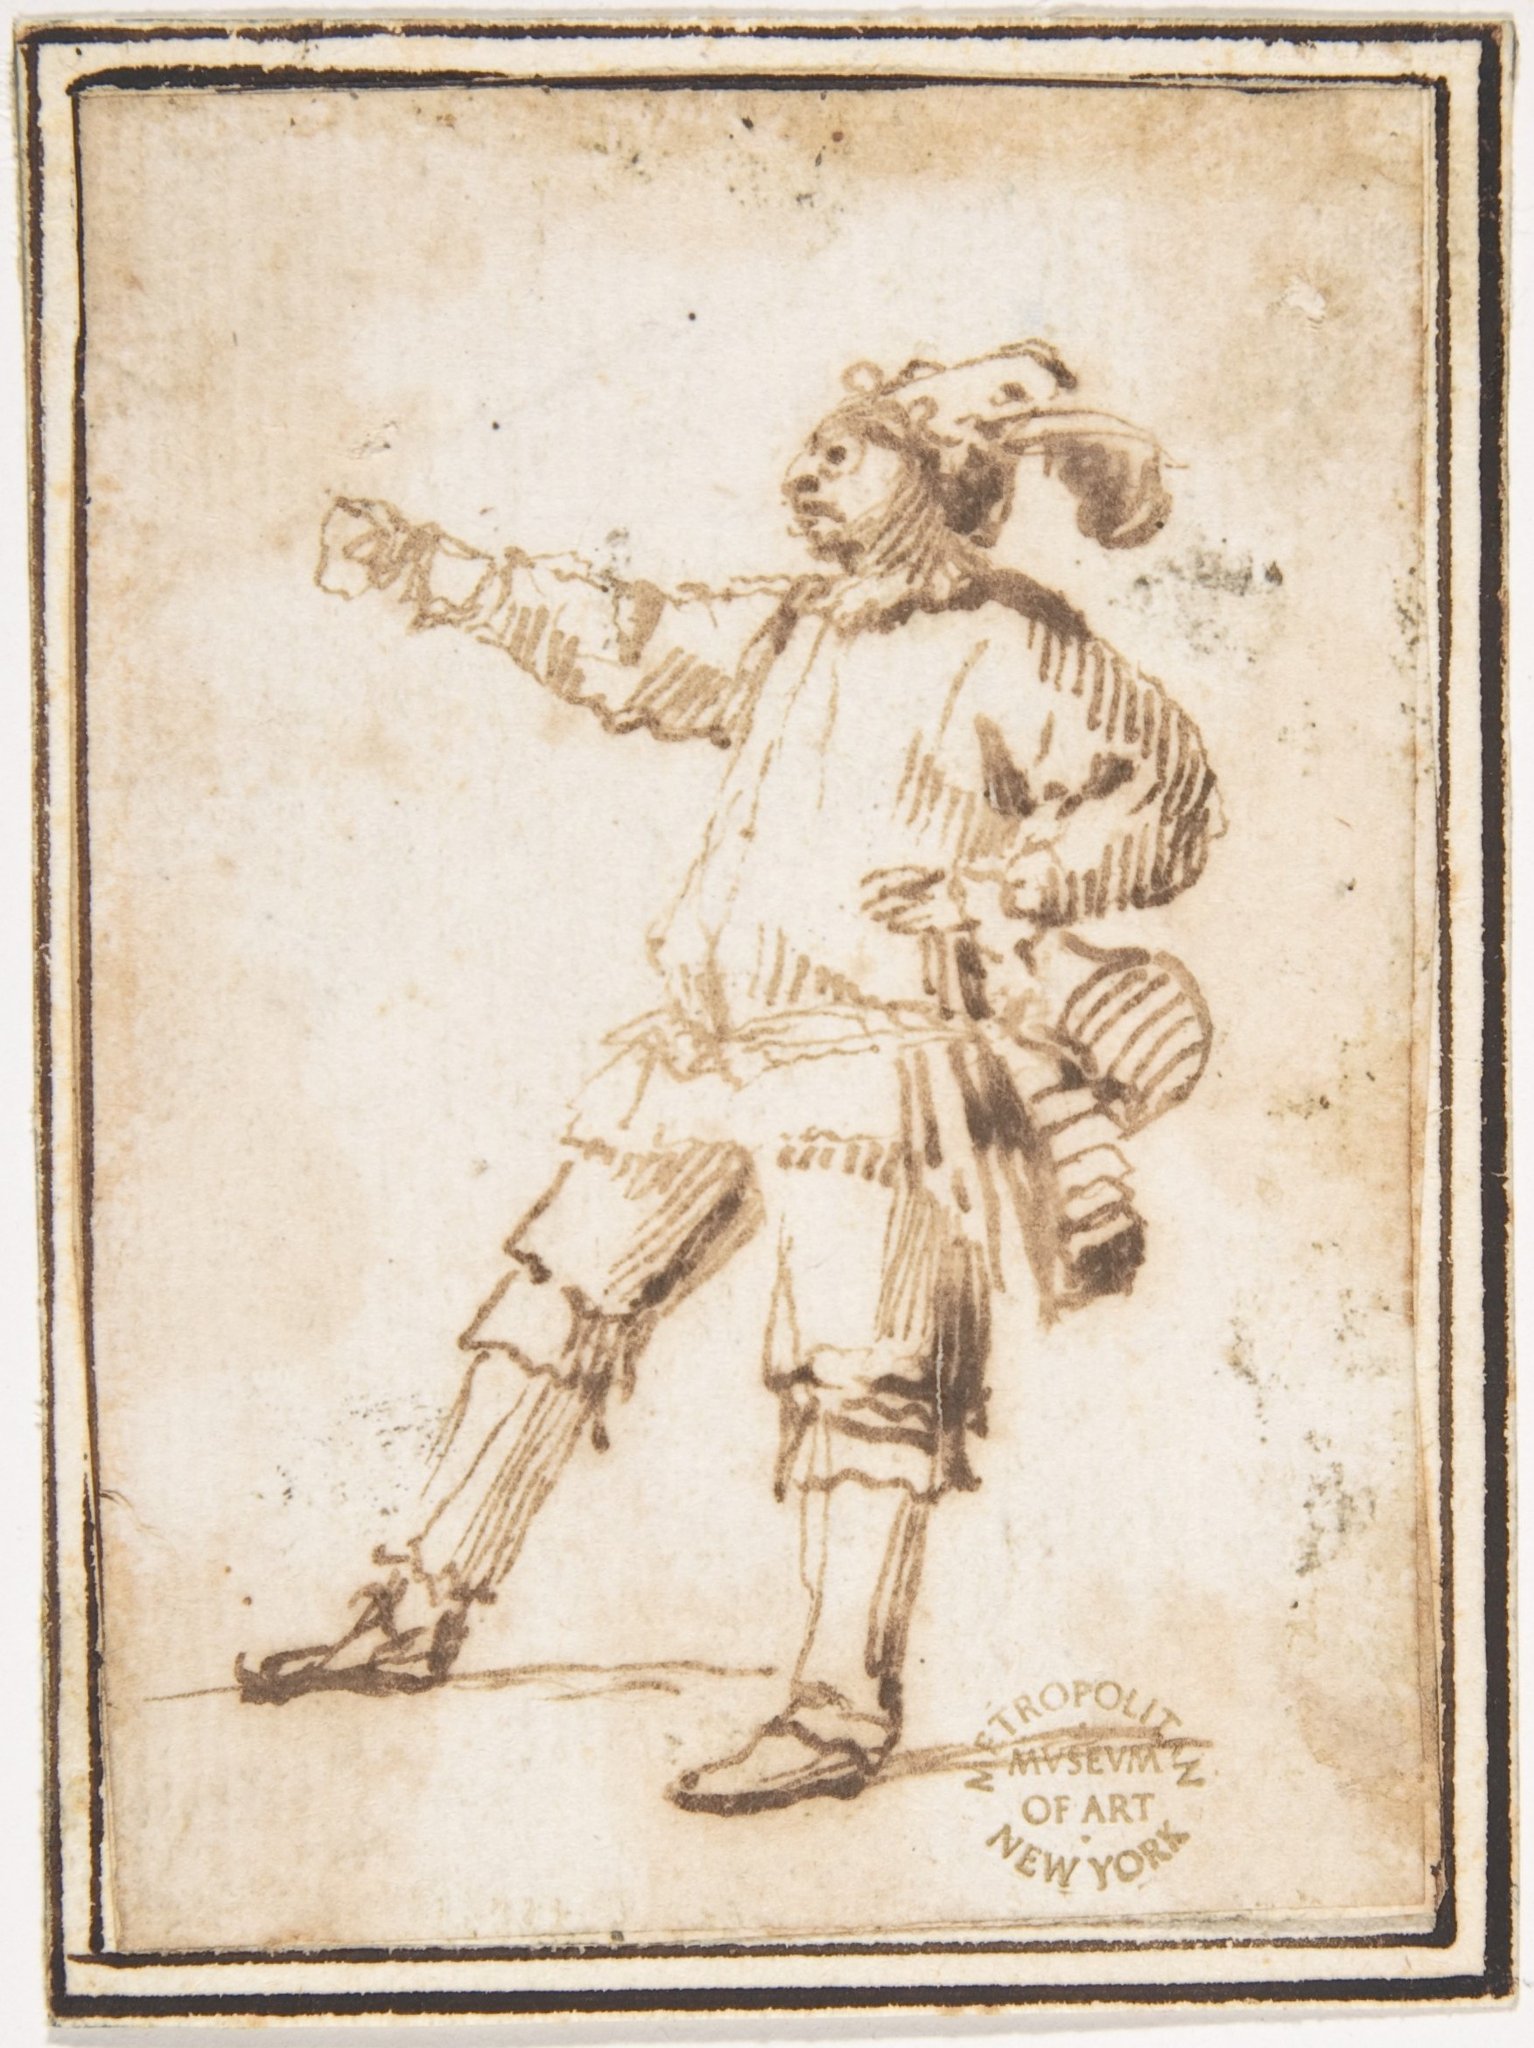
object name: drawing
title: Study of an Actor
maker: francesco allegrini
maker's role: artist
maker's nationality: italian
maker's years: 1615-1679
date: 1624-1663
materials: ink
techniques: pen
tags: men,actors